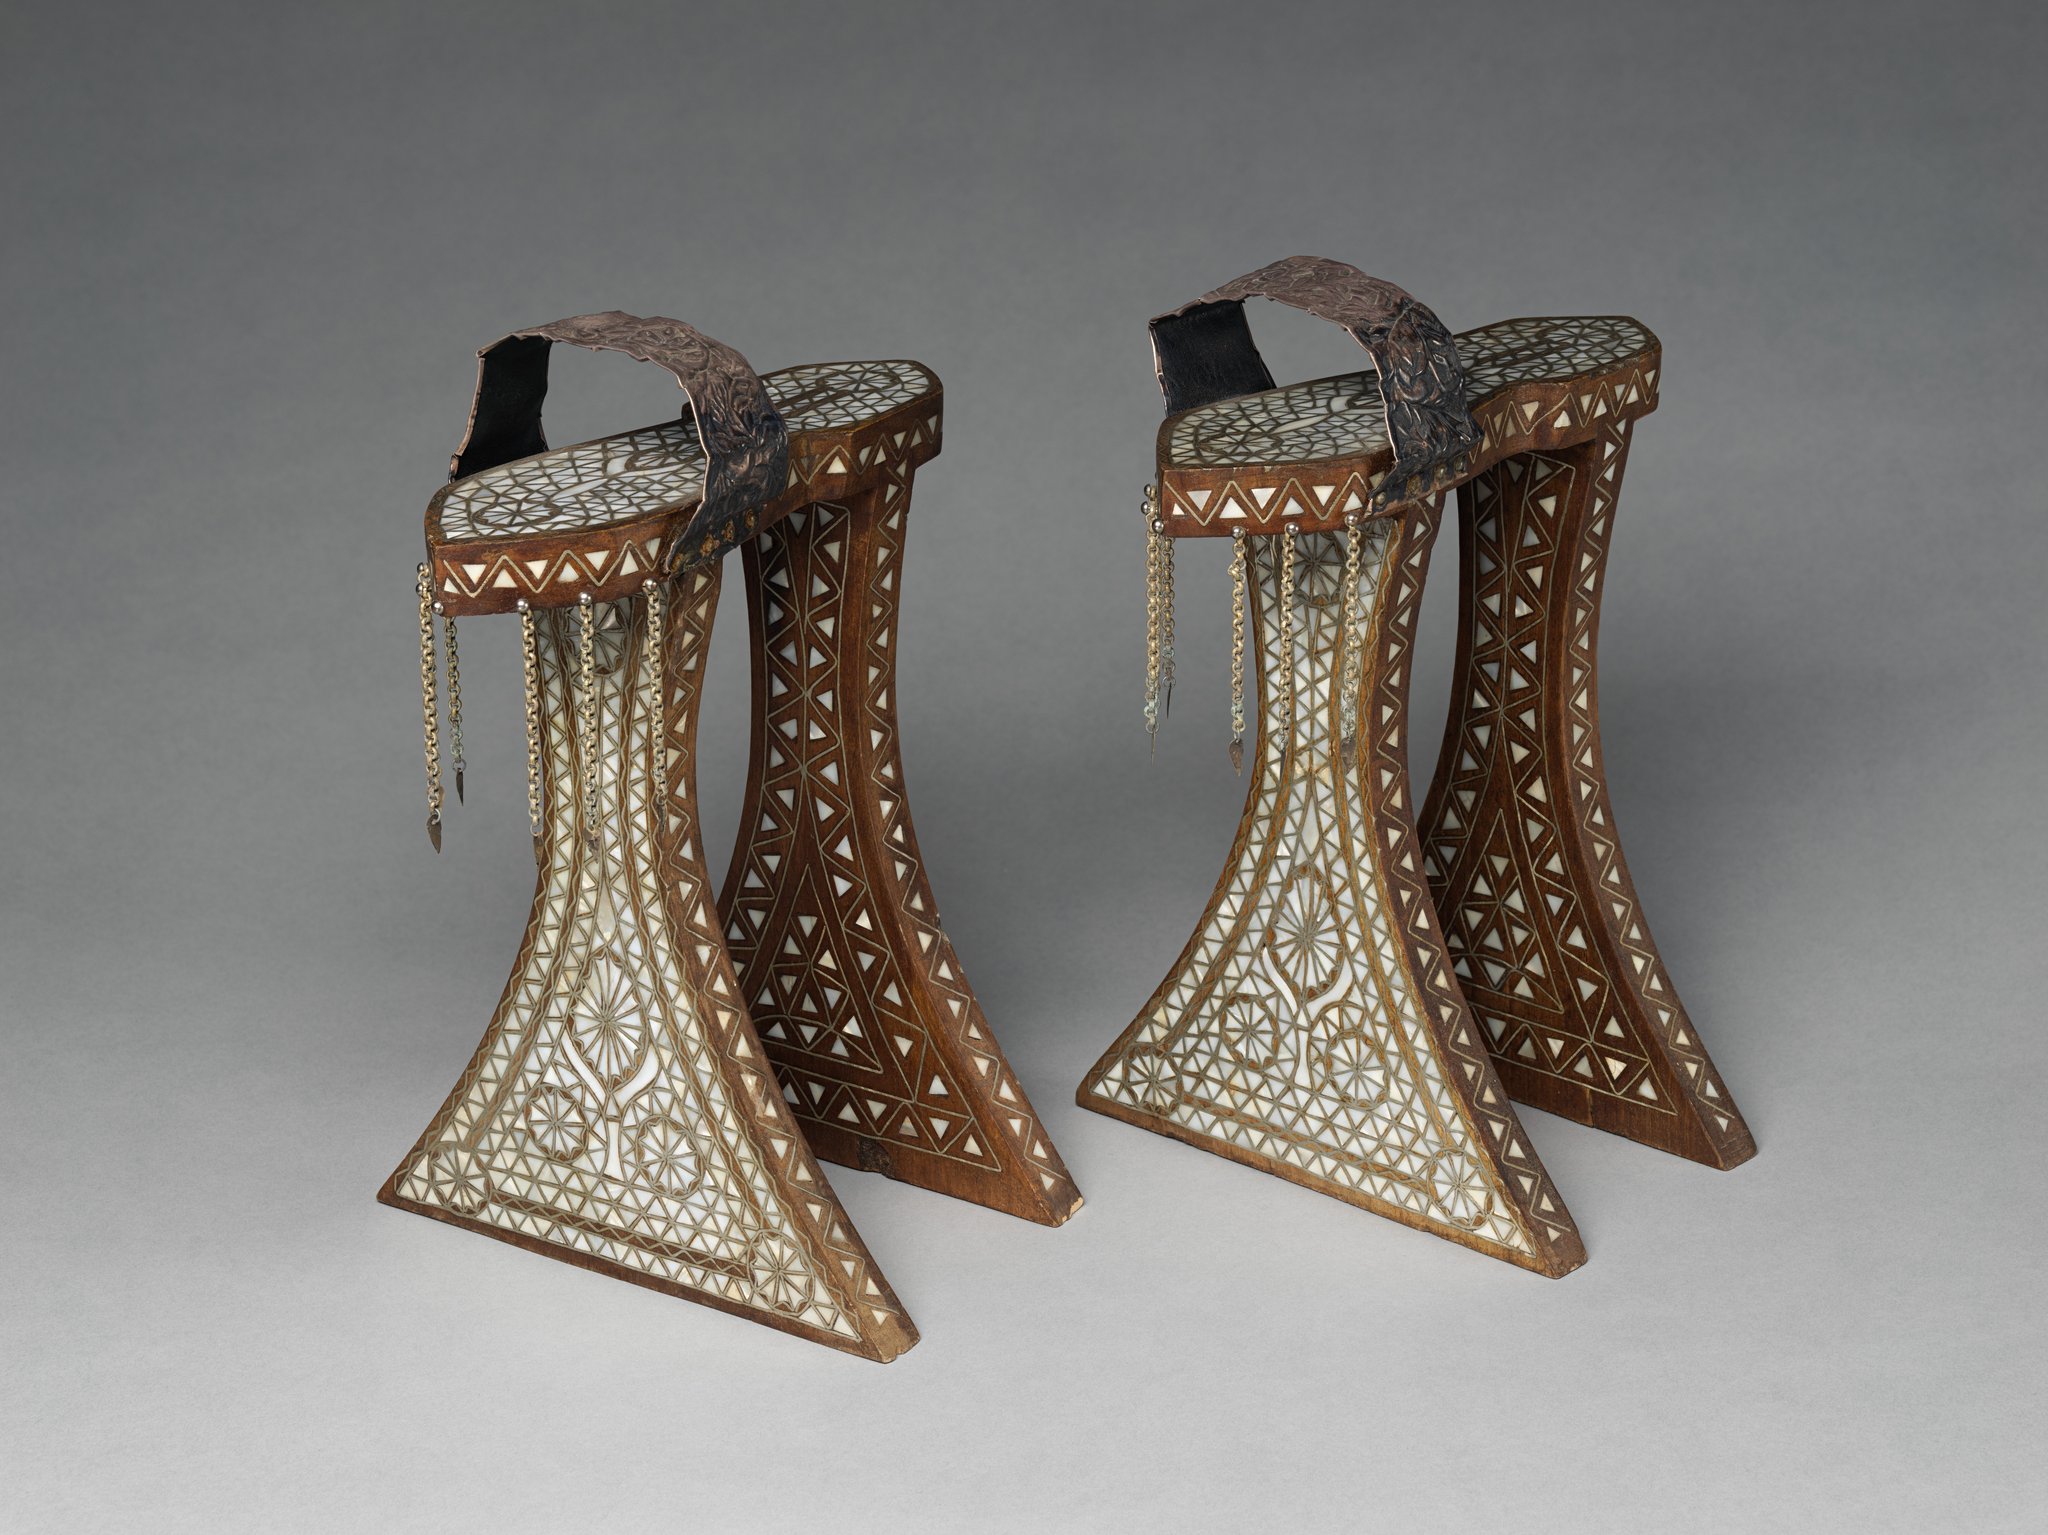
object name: shoe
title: Hammam Shoes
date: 1801-1900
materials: mother of pearl, silver, wood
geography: turkey